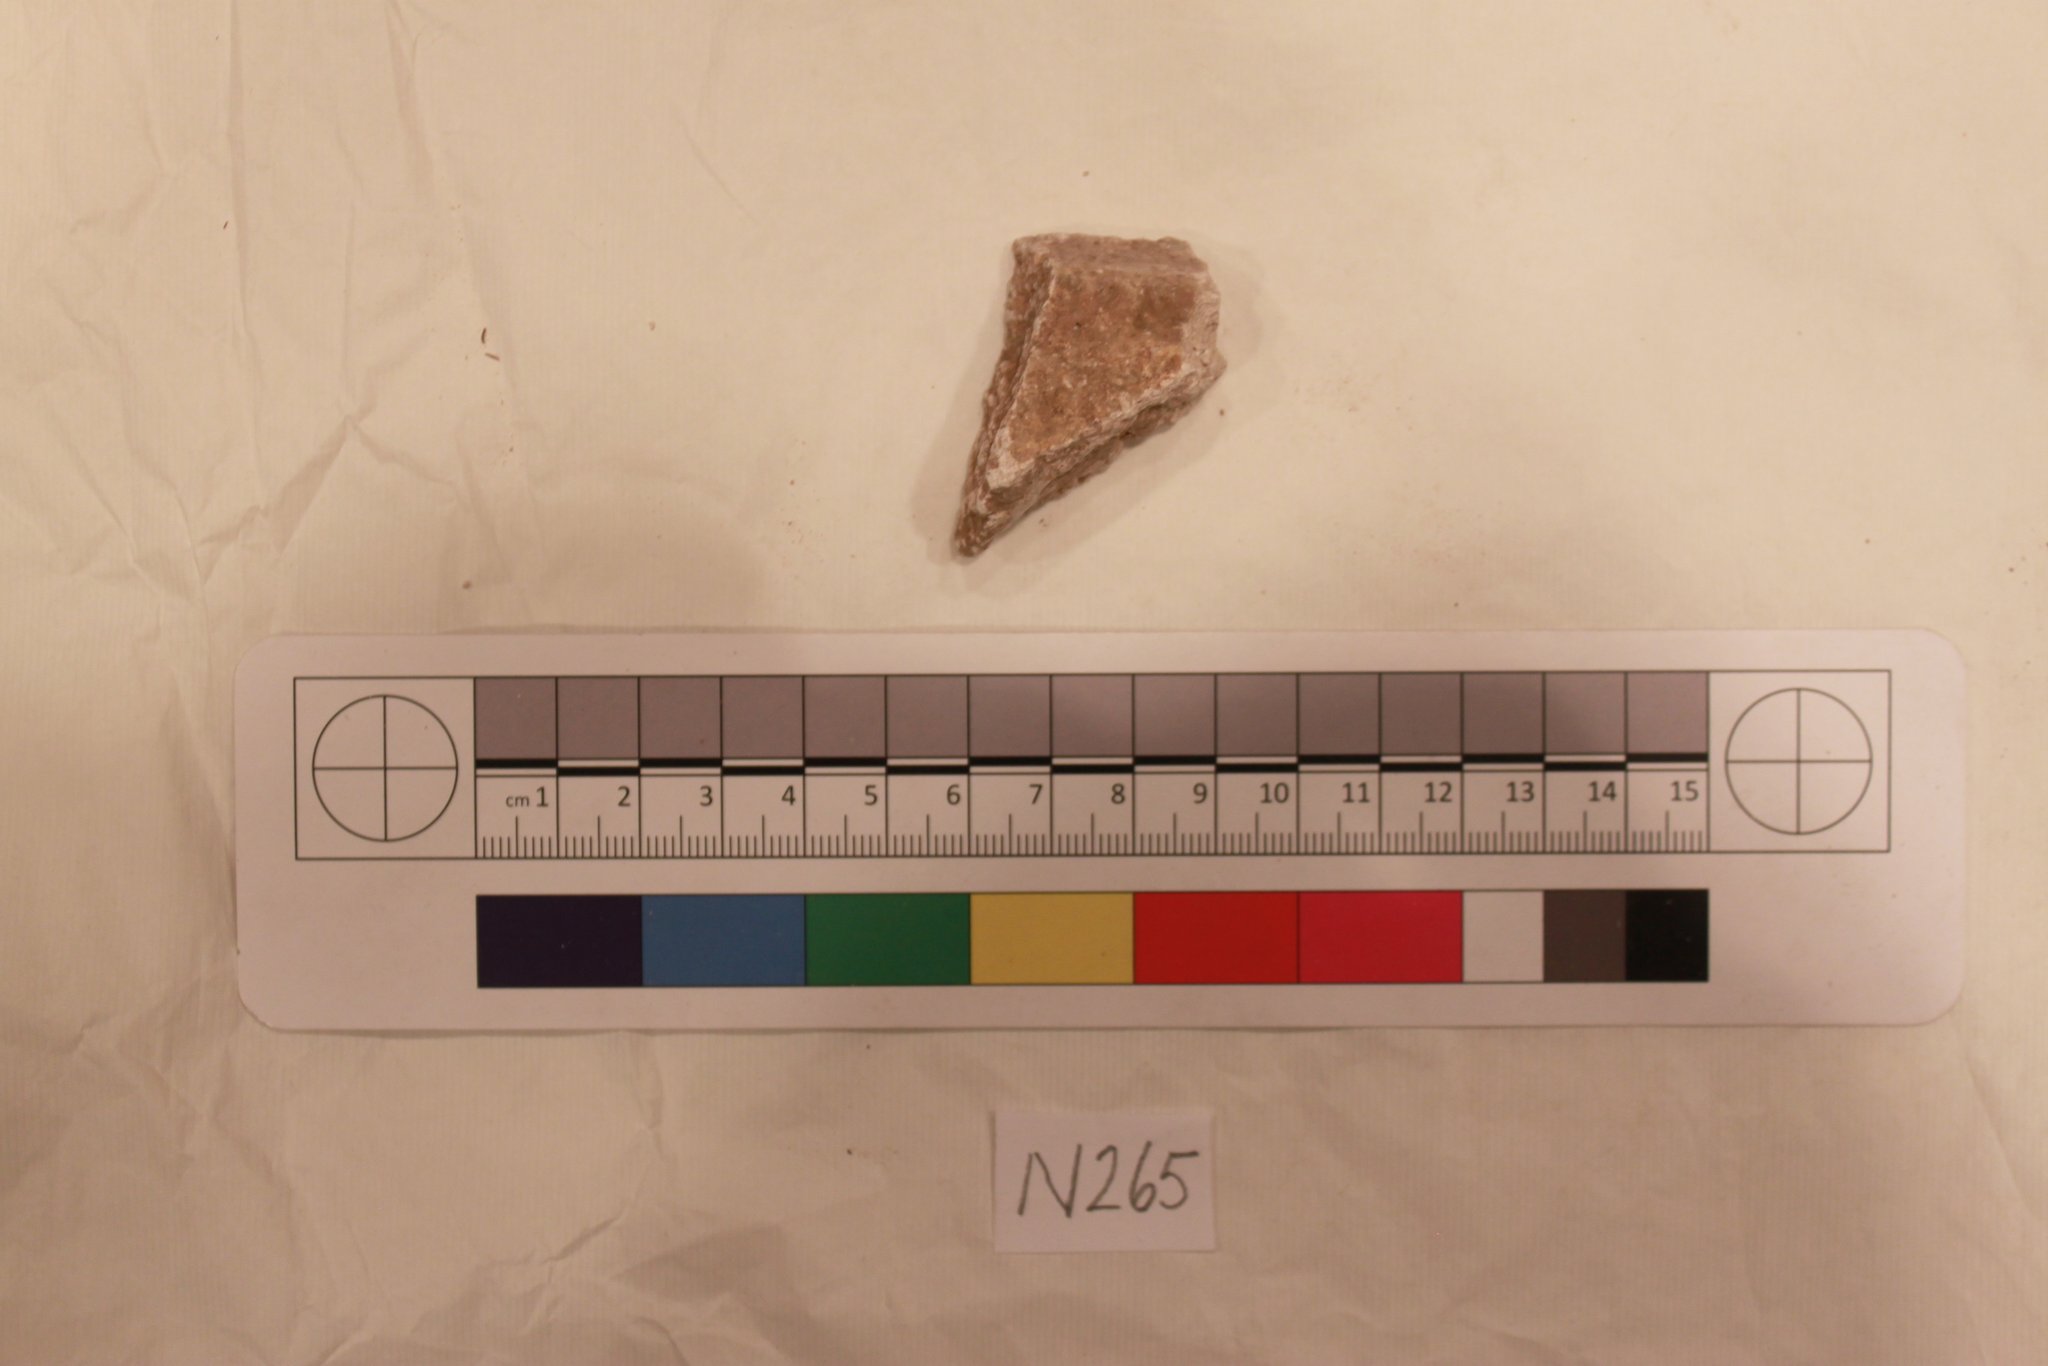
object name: fragment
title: Stucco Fragment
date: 701-1200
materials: plaster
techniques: carving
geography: iran